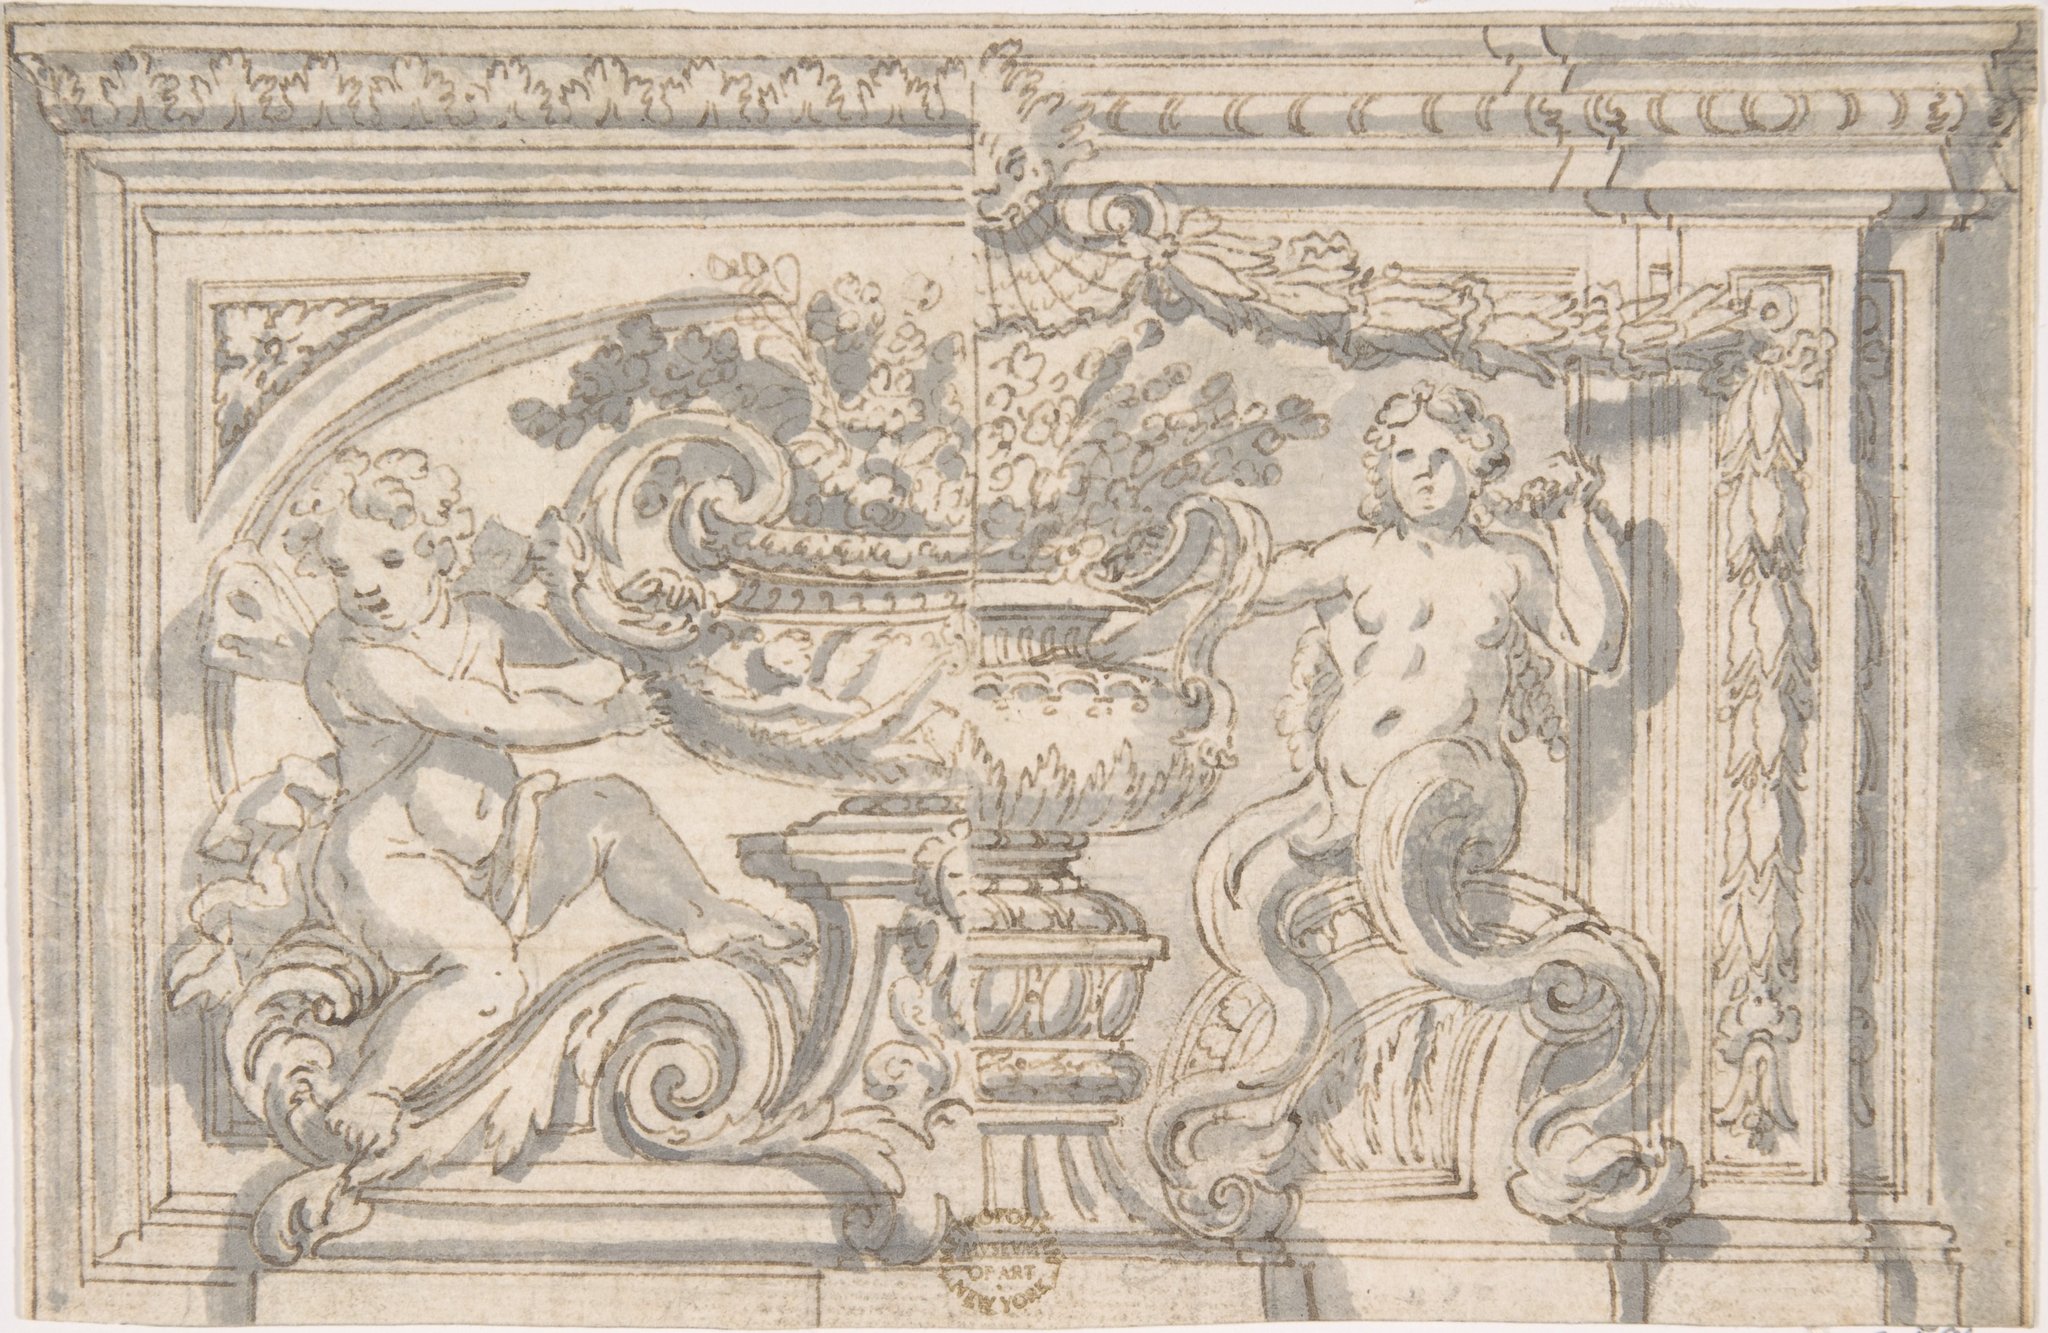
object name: drawing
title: Alternate Panel Designs with Urn and Putto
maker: anonymous, italian, 17th century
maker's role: artist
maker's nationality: italian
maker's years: 1600-1700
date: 1601-1700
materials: ink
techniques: brush, pen, wash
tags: garlands,cupid,urns